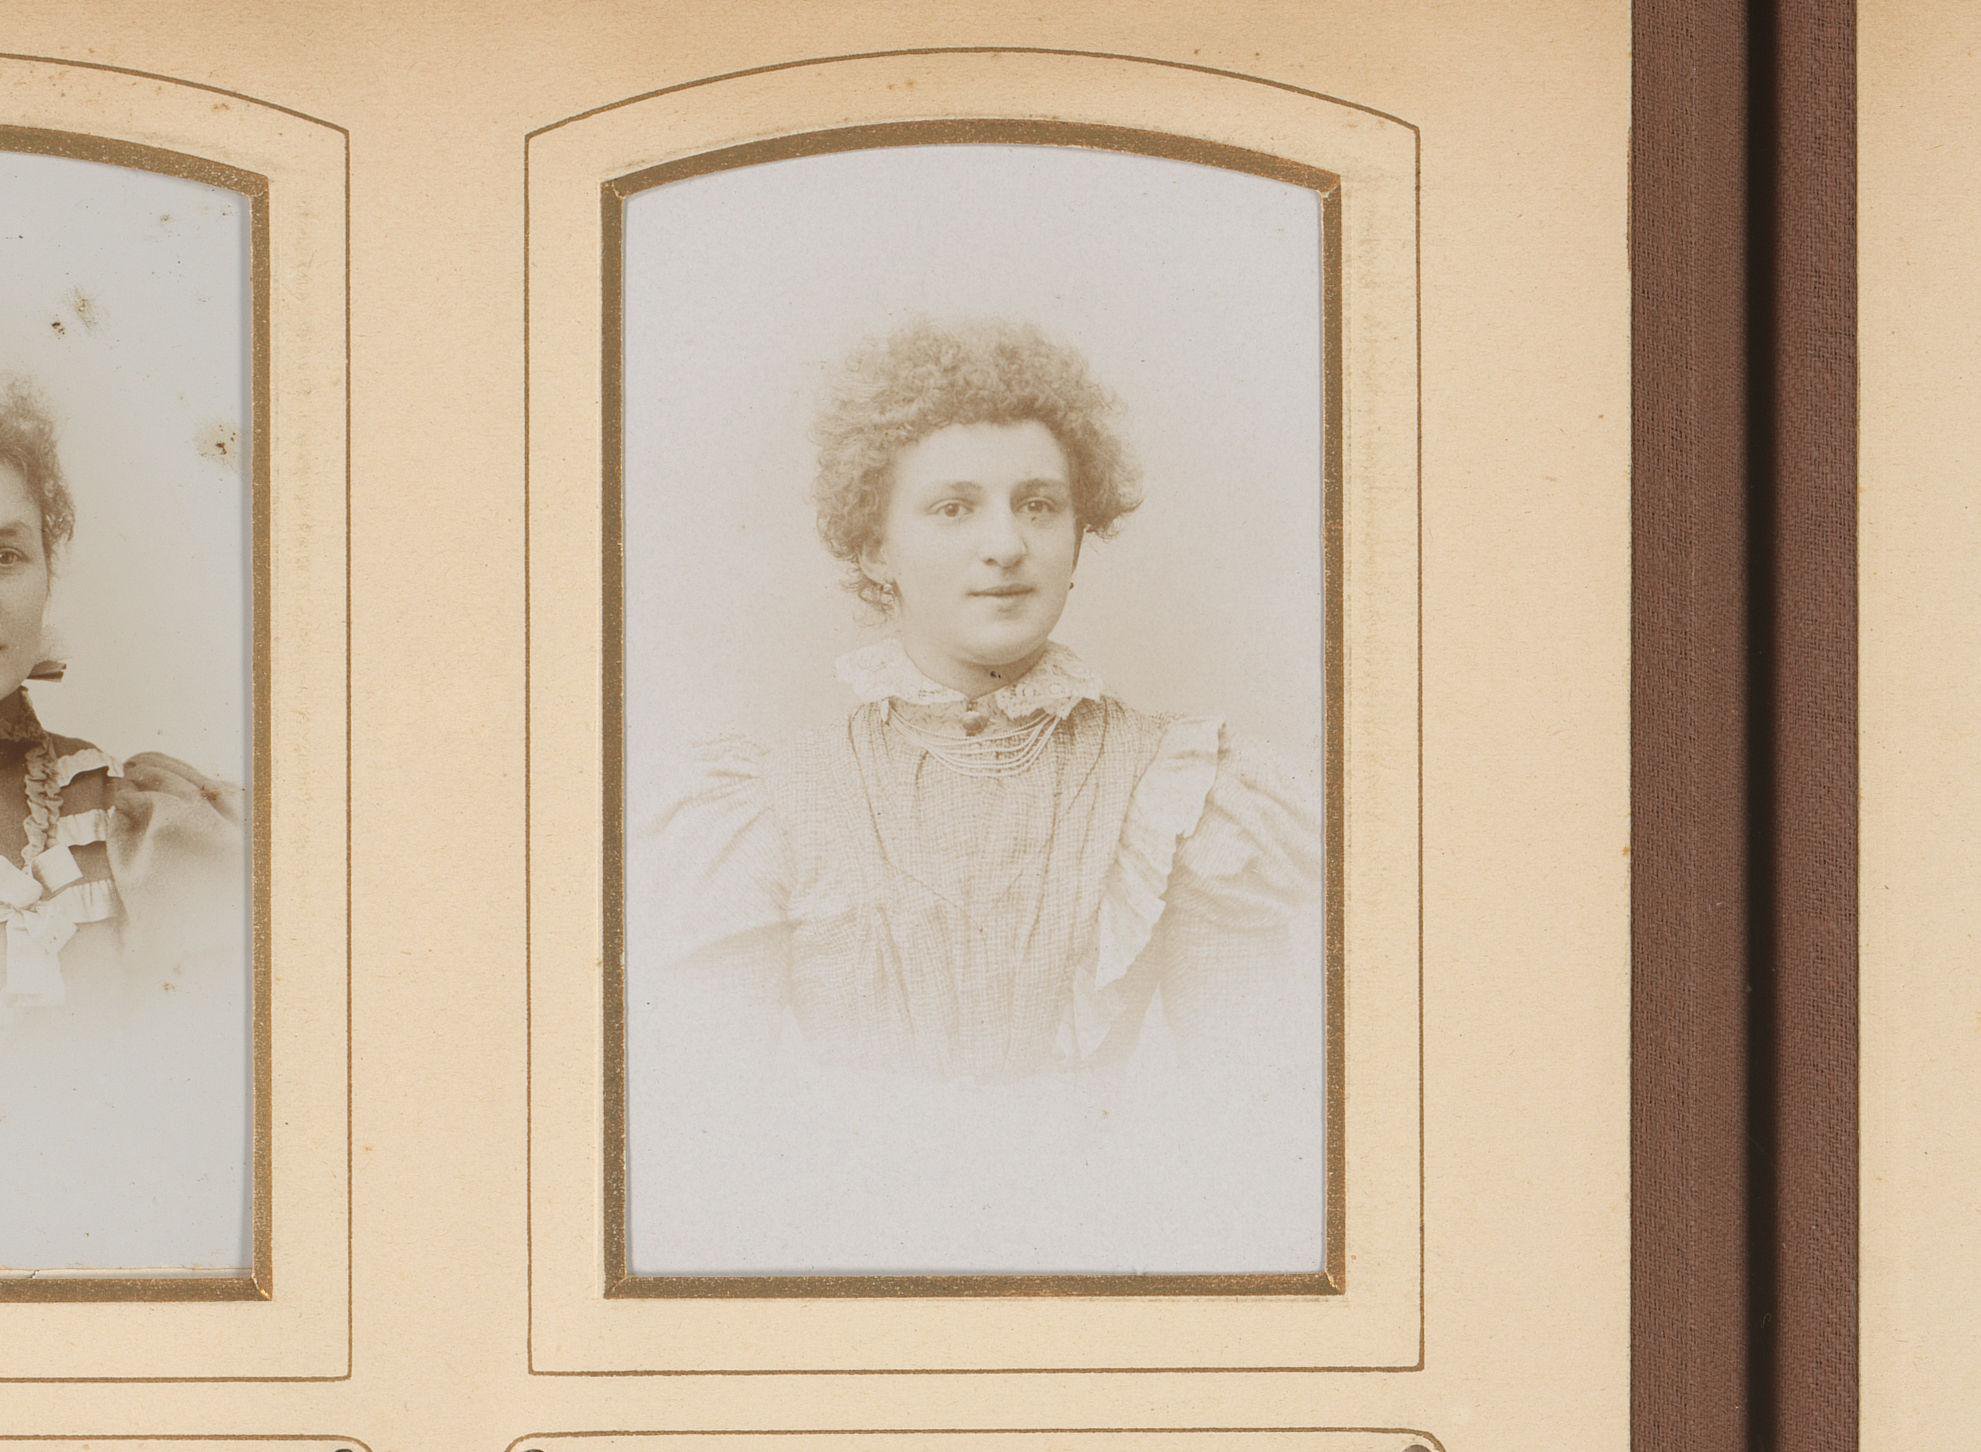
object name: album leaf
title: Portret van een jonge vrouw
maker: cornelis johannes lodewicus vermeulen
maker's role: fotograaf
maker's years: 1861-1936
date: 1888-1896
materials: cardboard, photographic support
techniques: collodion silver print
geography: amsterdam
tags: adolescent, young woman, maiden, historical persons - bb - woman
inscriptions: inscription: ‘C. J. L. Vermeulen/ Photographische Ateliers/ Amsterdam/ Heerenstraat 6 & Heiligenweg hoek Singel./ Specialiteit/ in Vergrootingen./ Telephoon/ 2339 u 40’